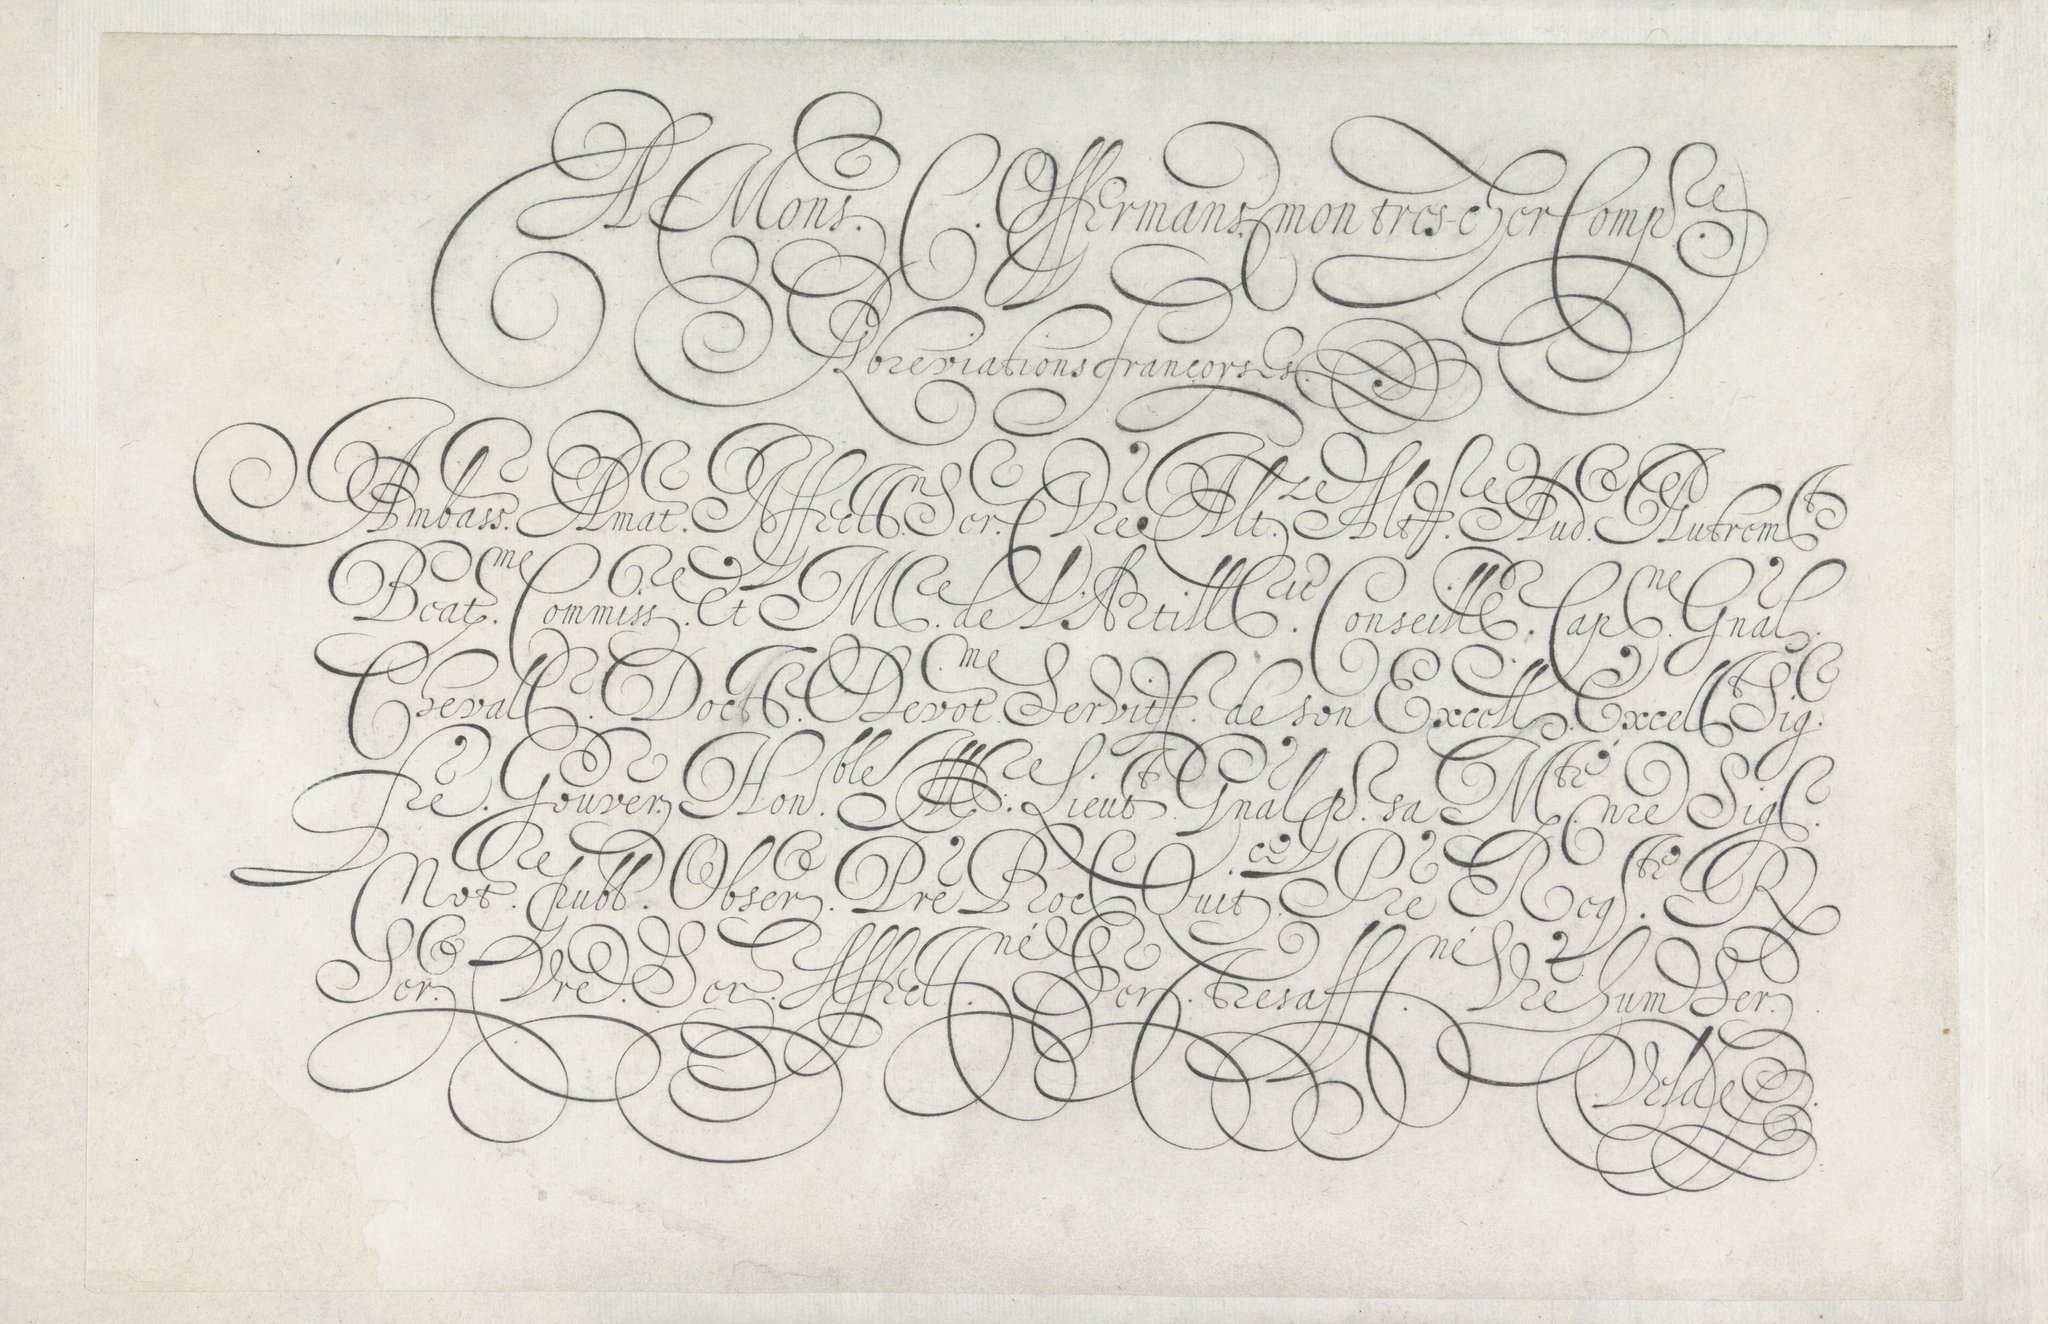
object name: album leaf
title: Spieghel der schrijfkonste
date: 1605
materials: ink, paper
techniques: calligraphy, pen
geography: rotterdam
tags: calligraphy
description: Kalligrafische tekening met de aanhef: A mons. C. Offermans ... Daaronder zes regels tekst in het Latijn, voornamelijk bestaande uit afkortingen: Ambass. Amat. ... De tekening maakt deel uit van een album.